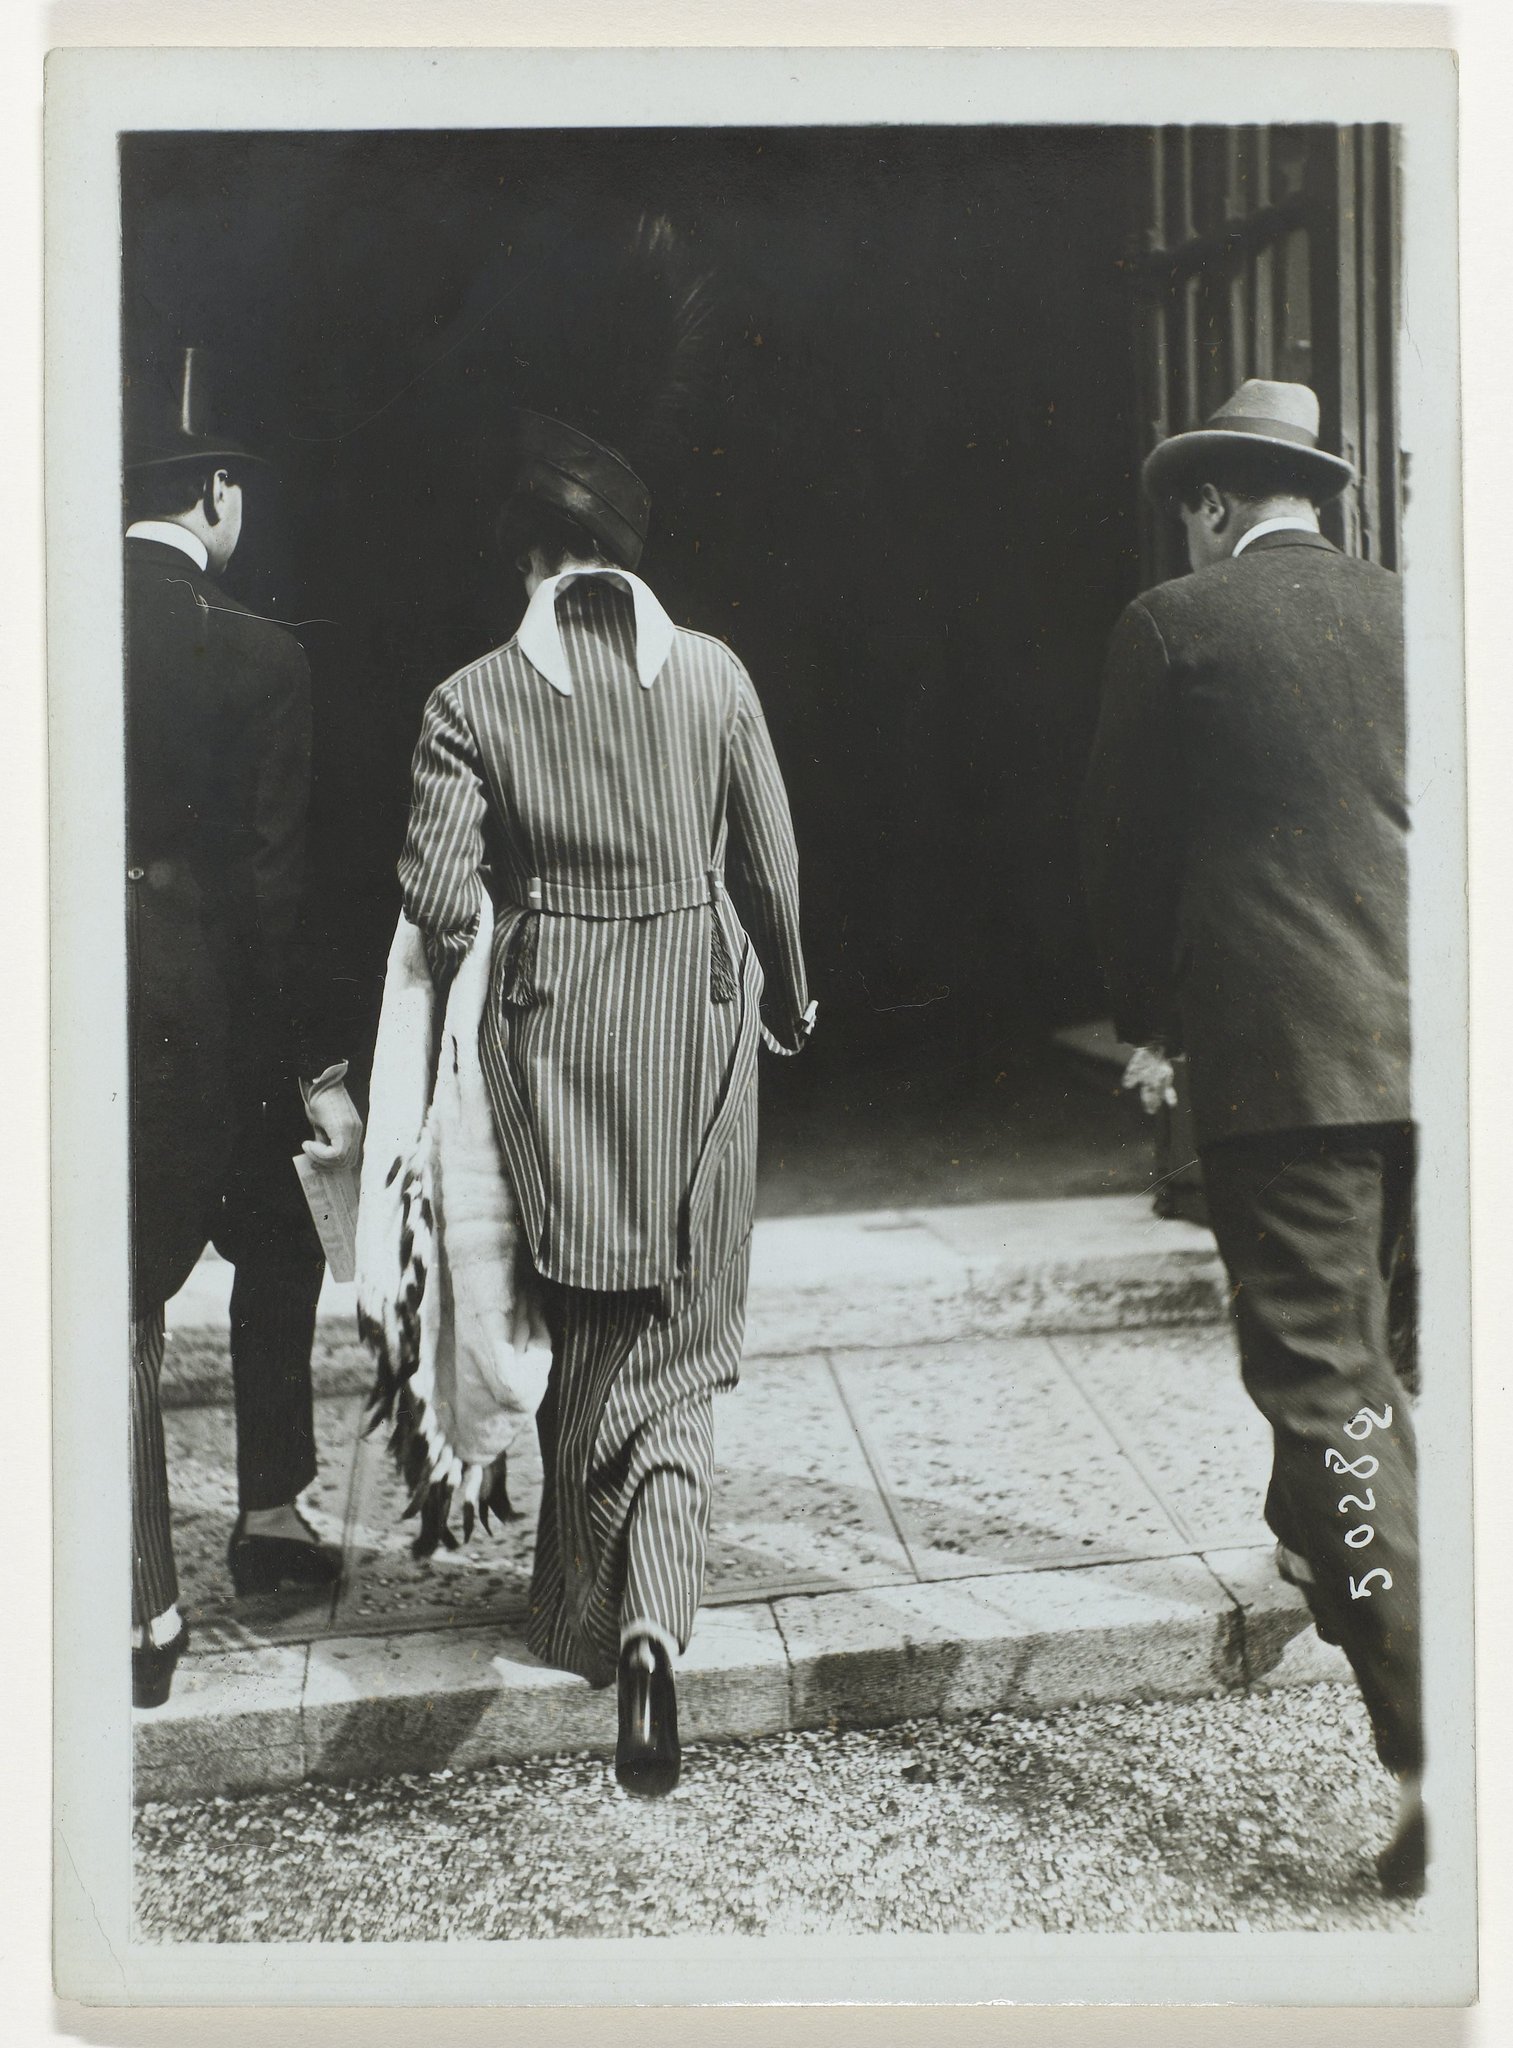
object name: photograph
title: Two Men and a Woman in the Street, Paris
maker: louis meurisse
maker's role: fotograaf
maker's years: 1873-1932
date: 1913-1914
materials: paper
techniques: gelatin silver print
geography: paris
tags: adult woman, adult man, paris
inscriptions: number: ‘50282 [?]’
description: Links een man in jacquet met een hoge hoed. Naast hem een vrouw in een gestreept kostuum met lange rok en een shawl over de arm. Rechts een man met een hoed op.